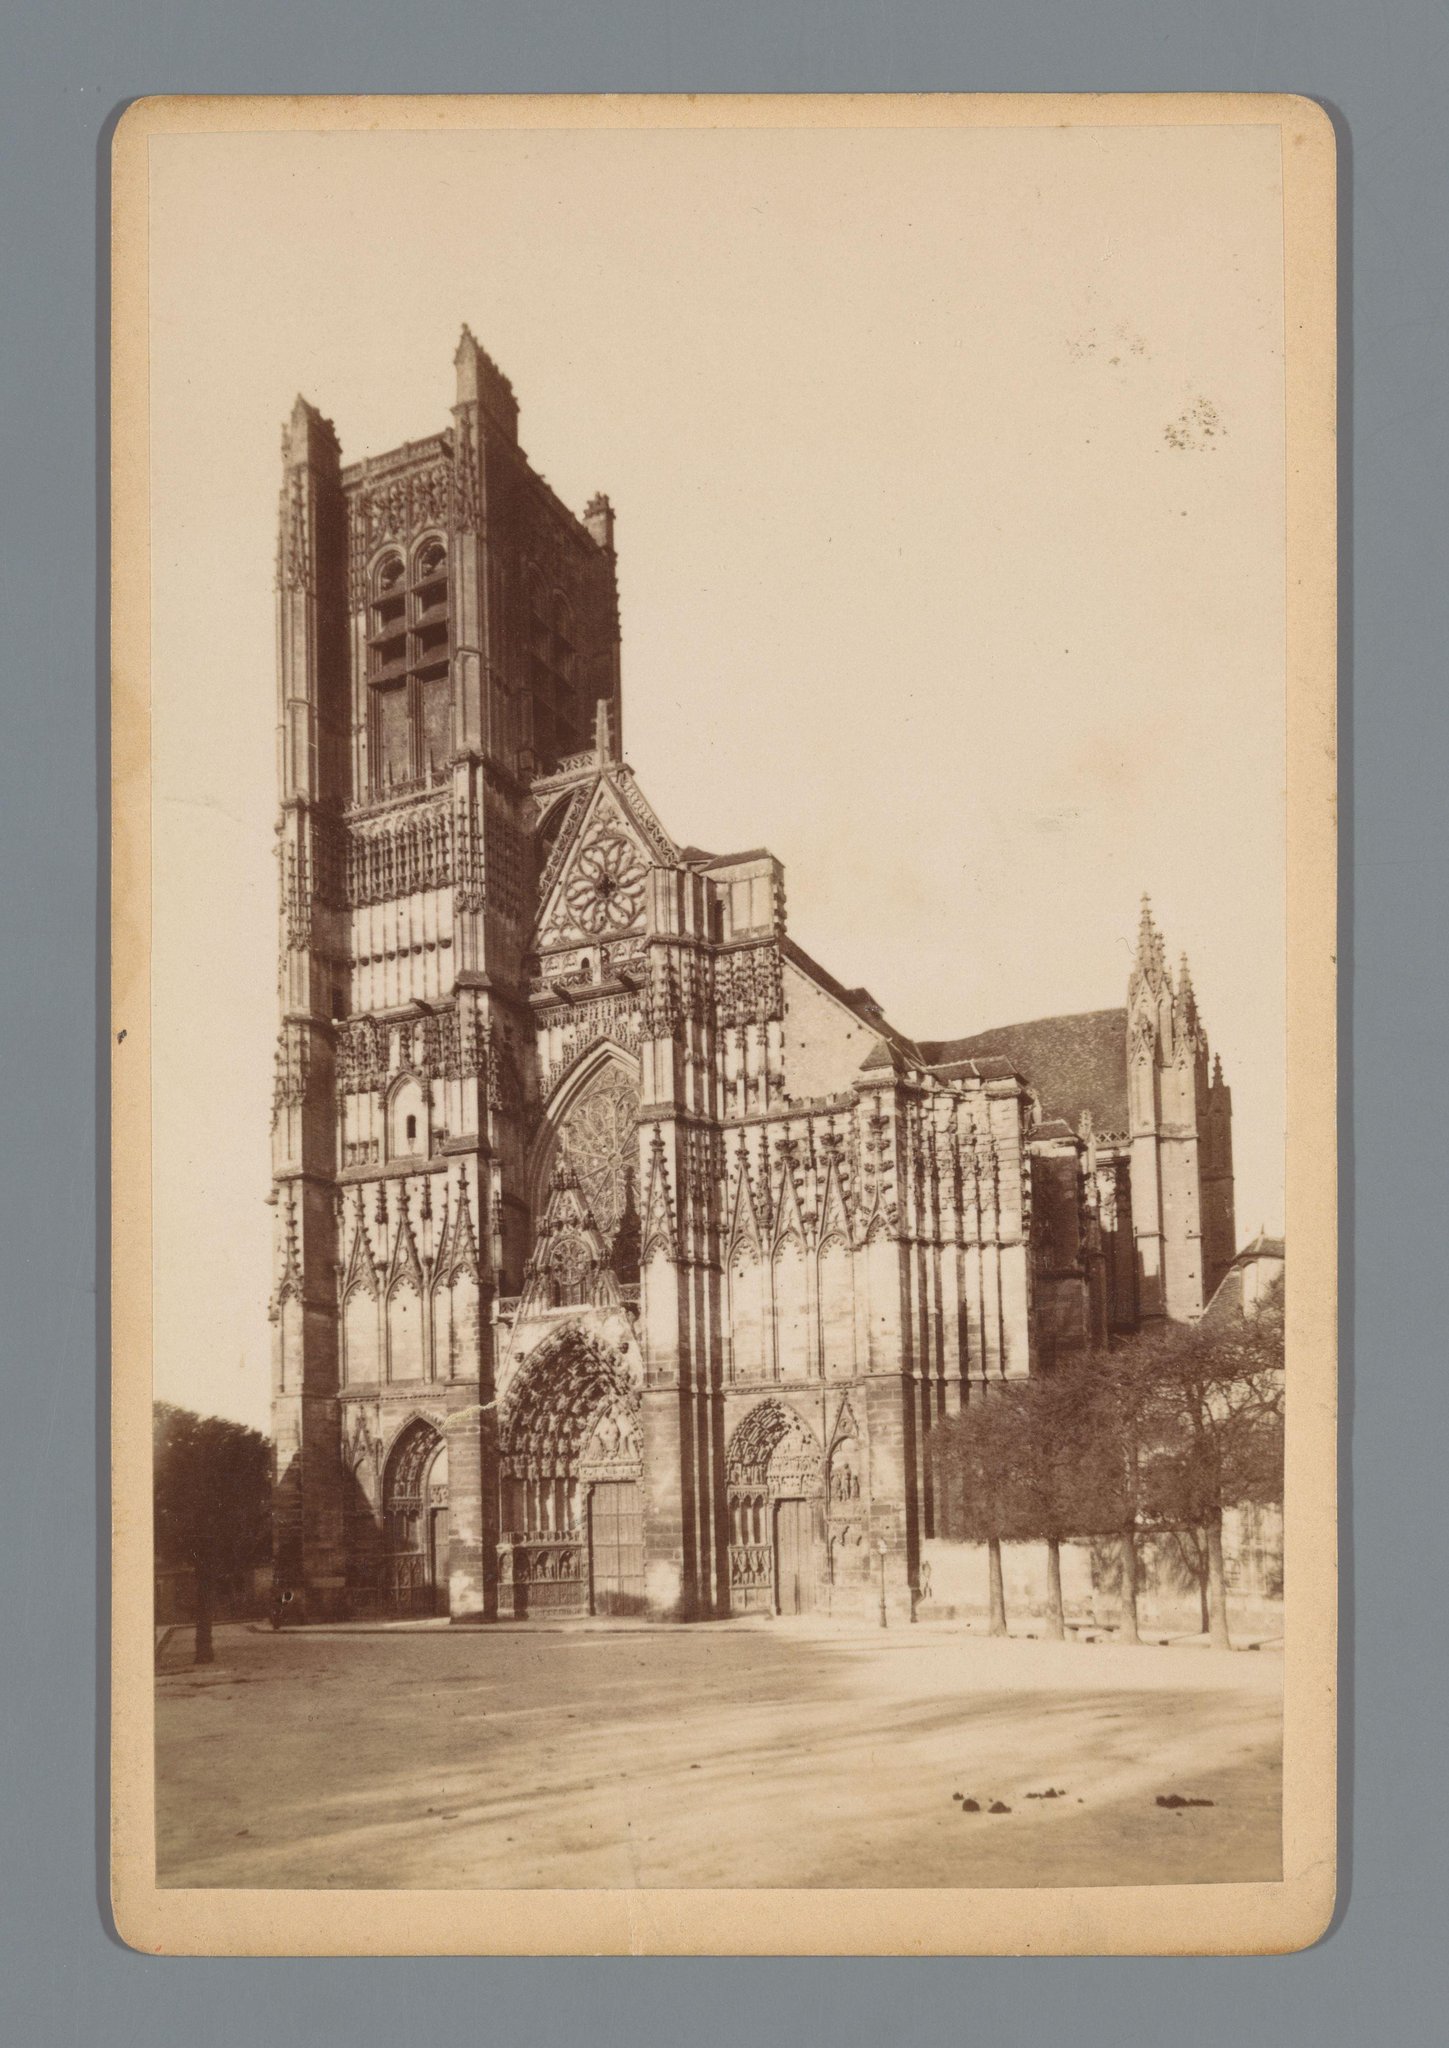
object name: cabinet photograph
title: Gezicht op de kathedraal van Auxerre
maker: louis maillet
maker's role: fotograaf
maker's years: 1845-1911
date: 1893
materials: cardboard, photographic support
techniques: albumen print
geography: auxerre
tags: church (exterior), façade (of house or building)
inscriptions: retailer's mark: ‘Ancienne Maison Colombier/ 4, Rue de Temple, 4/ AUXERRE/ MEDAILLE d'ARGENTAL EXPOSITION 1882/ (...)’, annotation: ‘Auxerre, 9 Juillet 1893, Cathedrale’